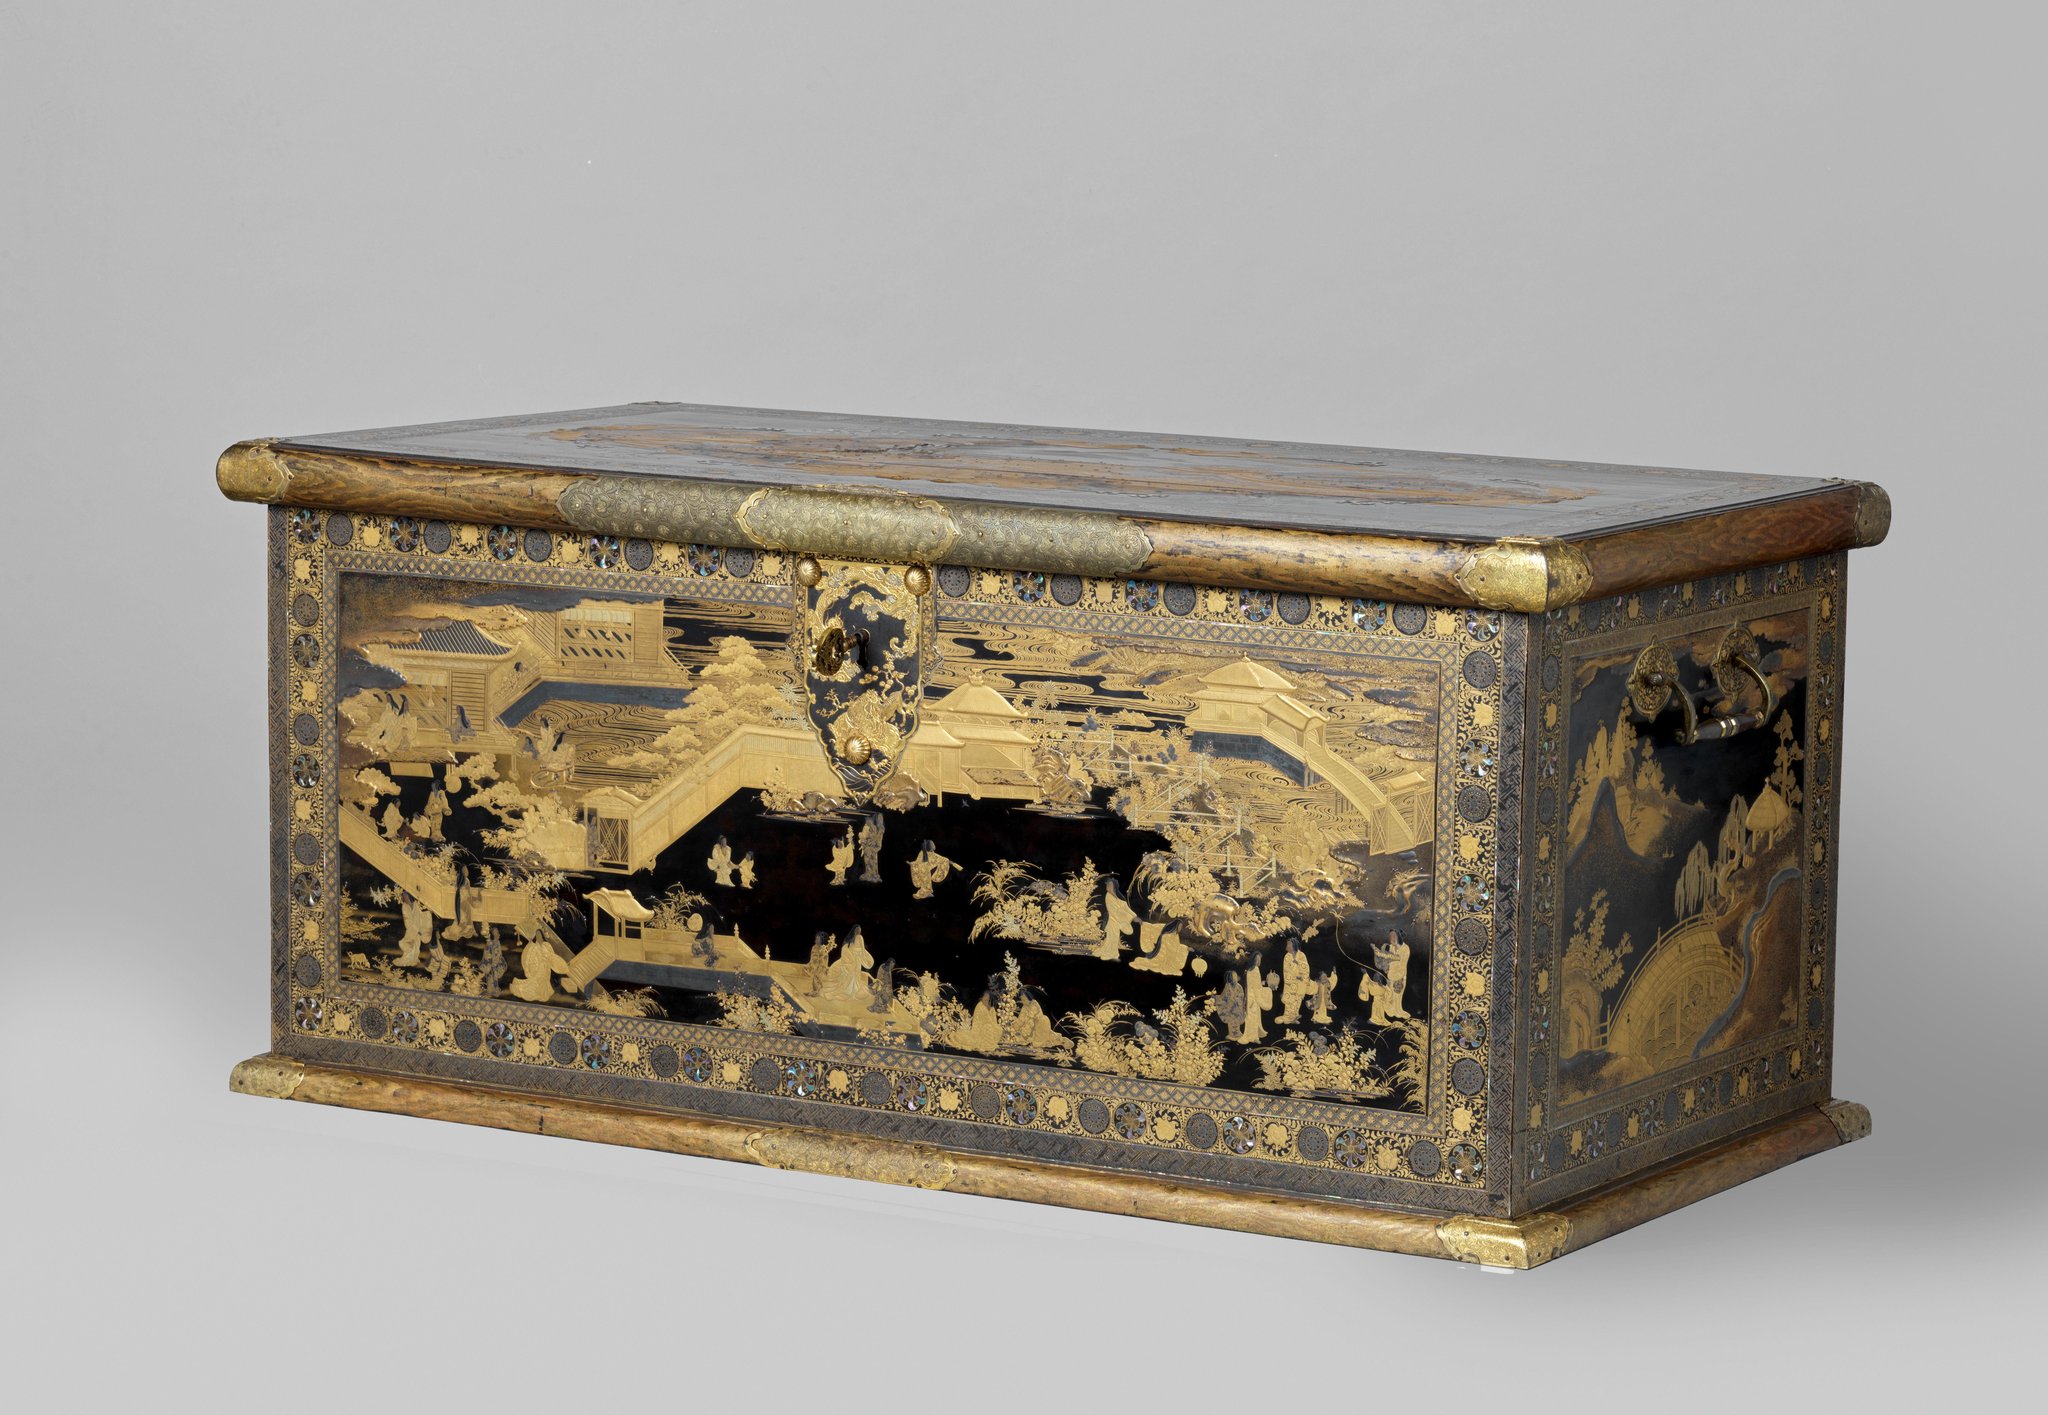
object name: chest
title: The Amsterdam Chest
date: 1635-1645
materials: copper, gold powder, lacquer, mother of pearl, silver, wood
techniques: metalworking, inlay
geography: kyoto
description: Few lacquer chests of this quality exist. The execution is highly detailed, with drops of silver to represent the dew and each kimono decorated differently. An episode from an 11th-century Japanese tale about the adventures of Prince Genji appears on the front. The Dutch were the only Europeans to have access to Japan, where the Dutch East India Company (VOC) commissioned fine lacquer pieces for wealthy burghers.